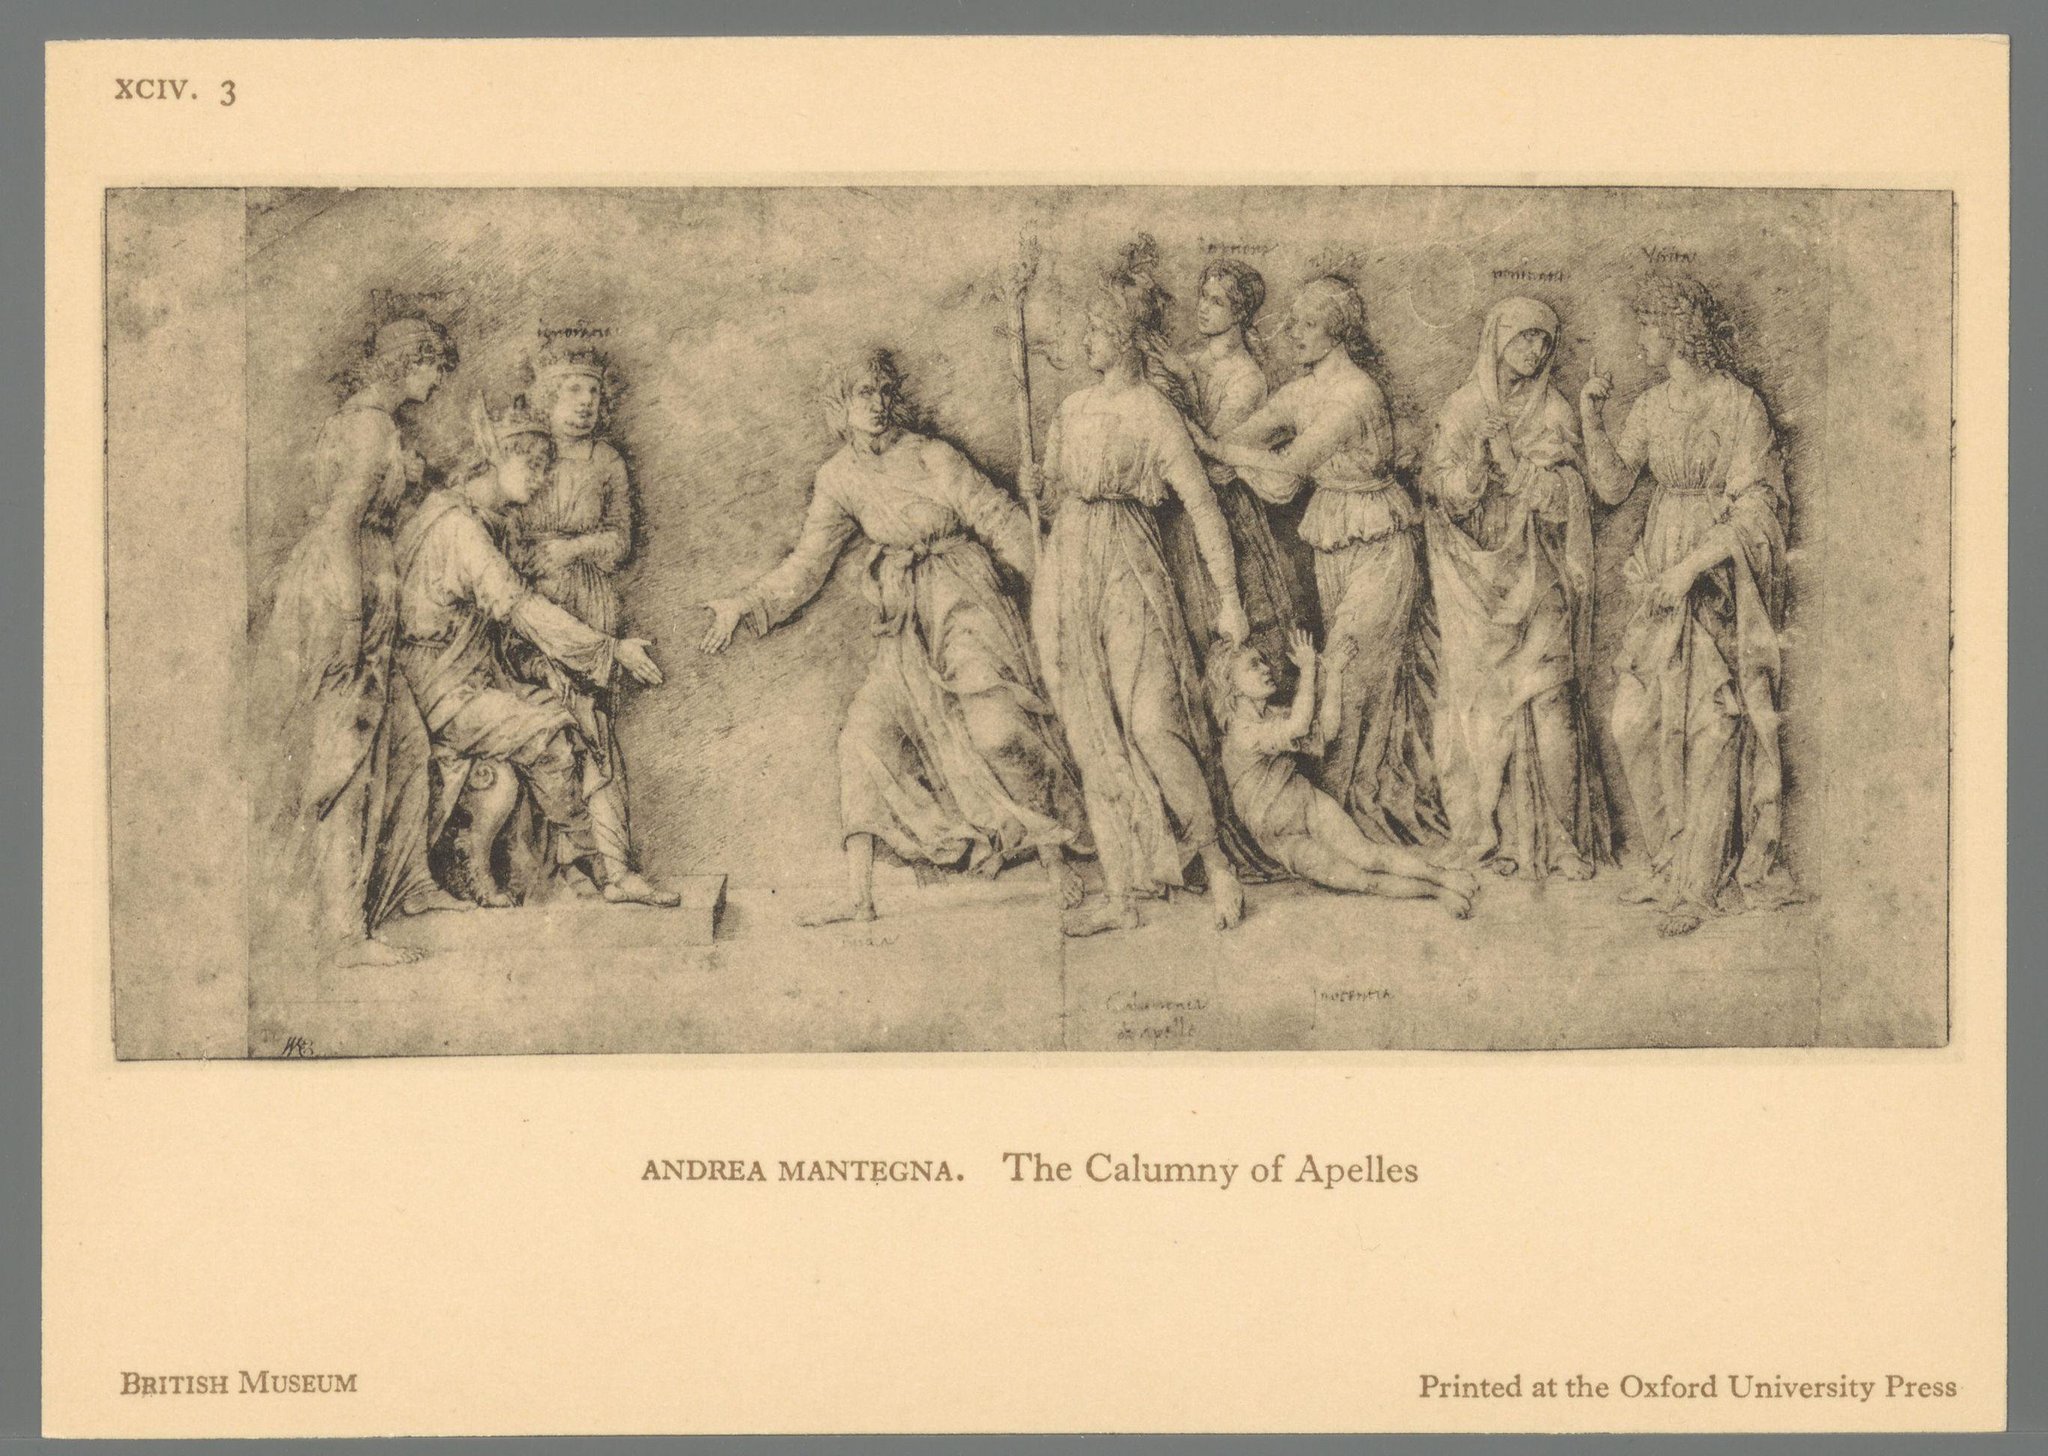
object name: reproduction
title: Andrea Mantegna. The Calumny of Apelles. British Museum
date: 1902-1950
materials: cardboard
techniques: photograph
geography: oxford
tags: drawing, sketch, permanent exhibition, museum